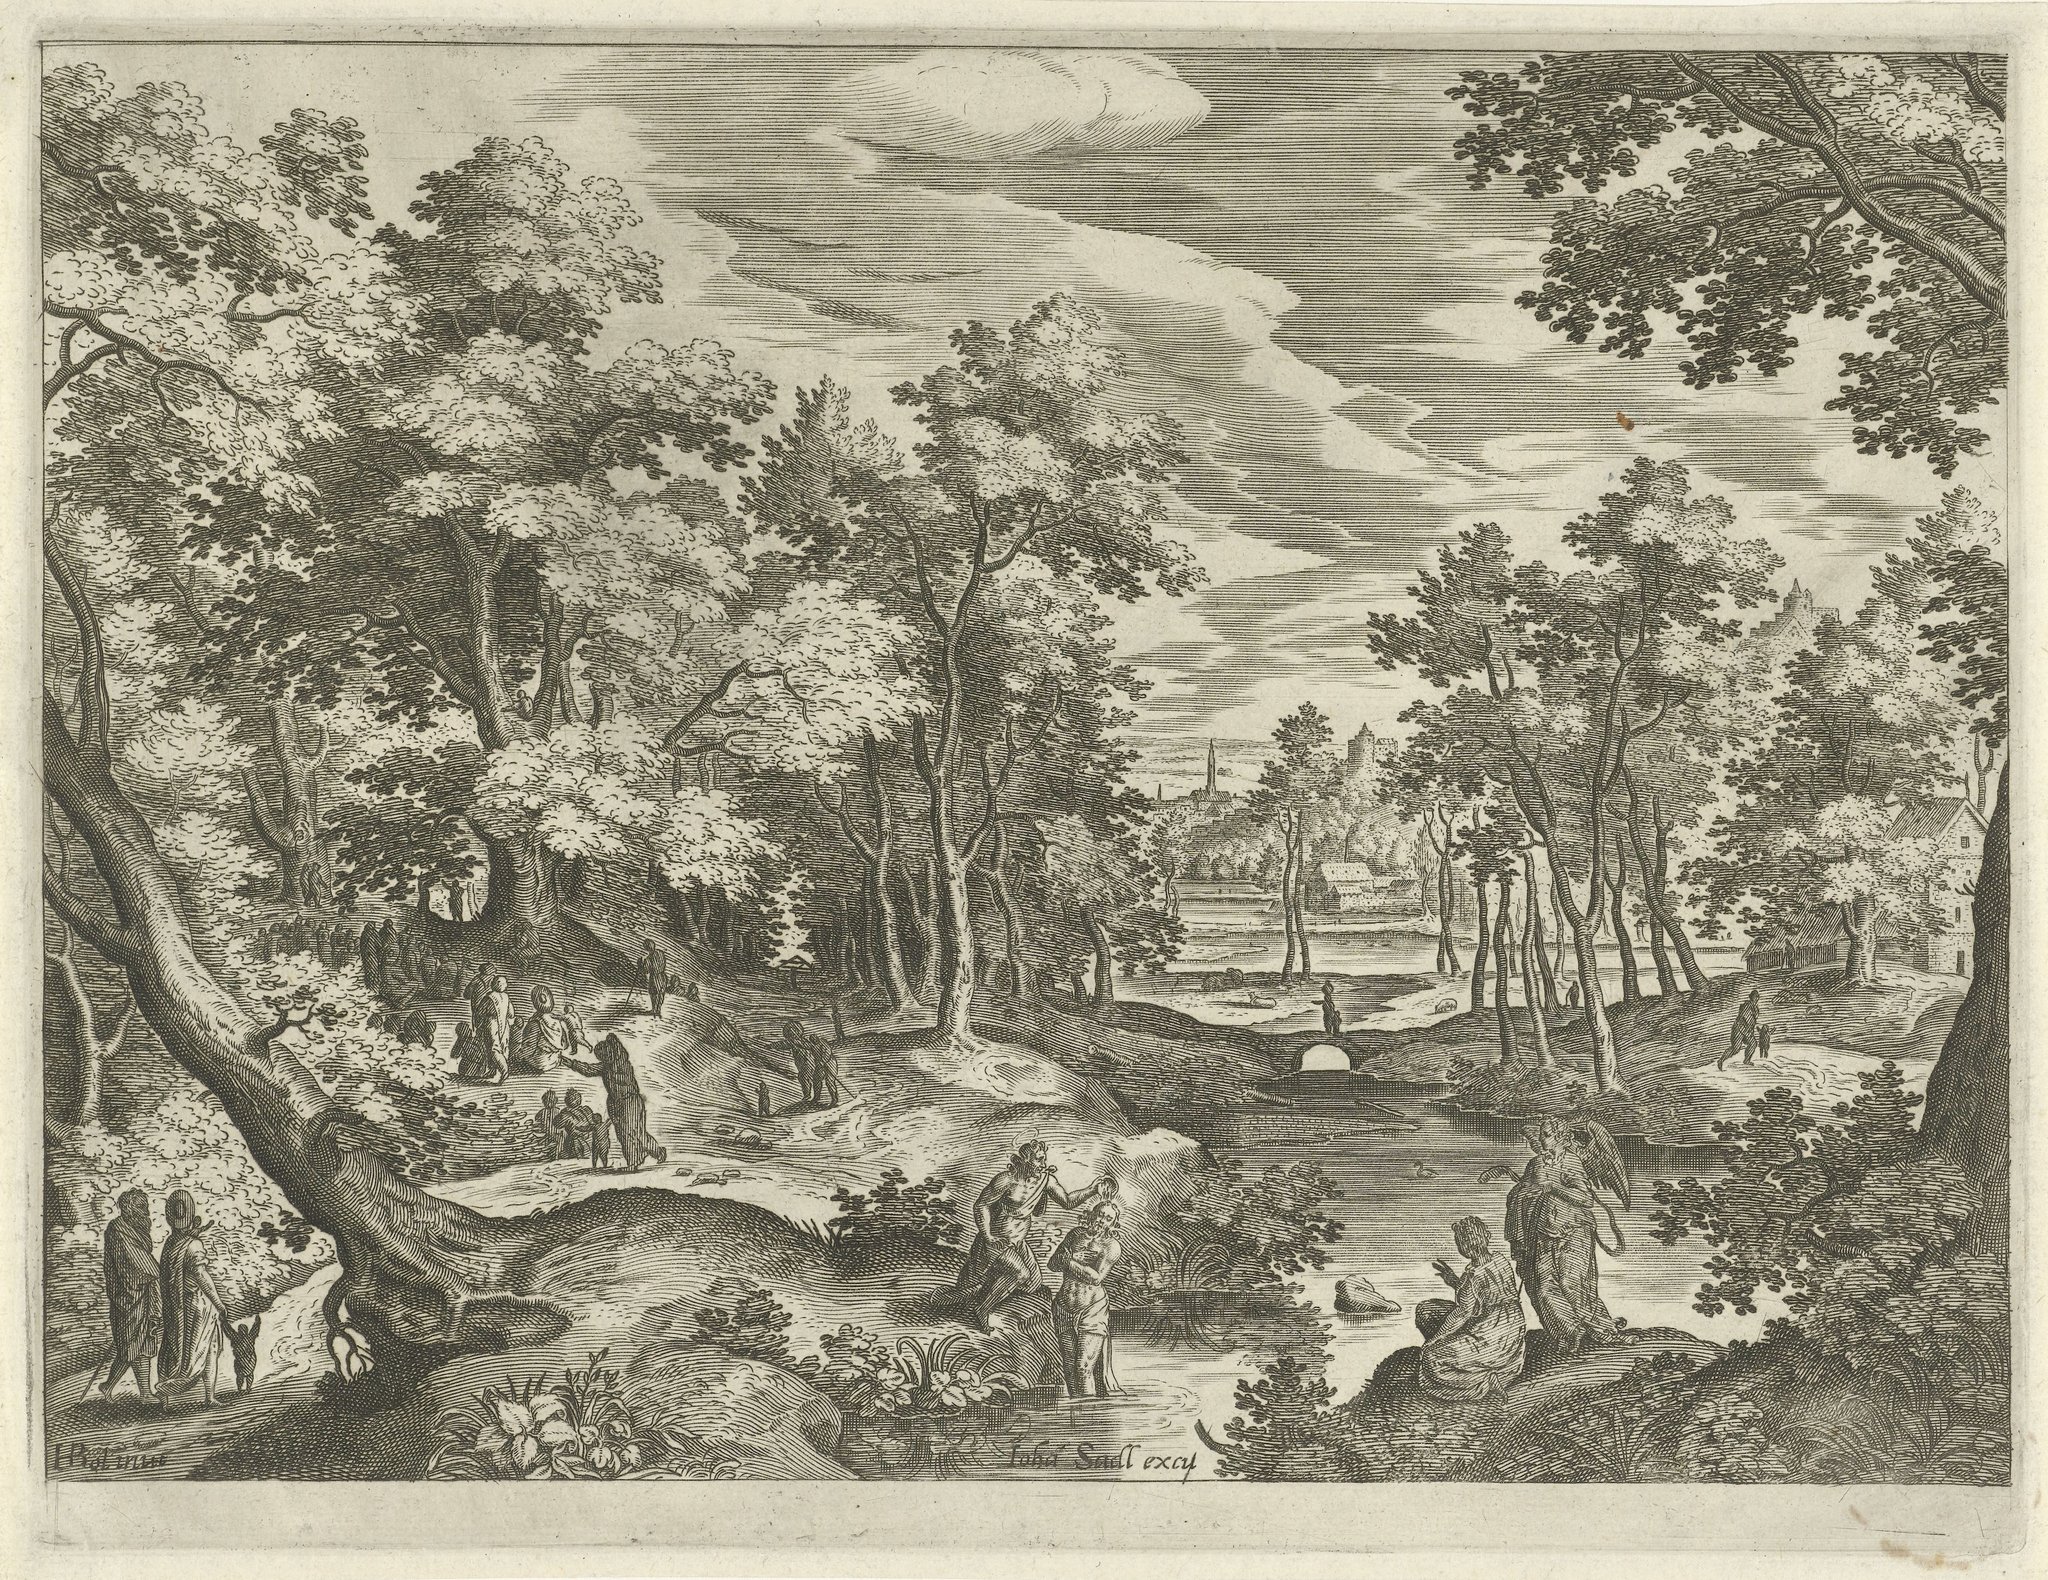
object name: print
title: Landschappen met scènes uit het Oude en Nieuwe Testament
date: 1580-1600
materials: paper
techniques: engraving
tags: baptism of christ in the river jordan: john the baptist pouring out water on christ's head: the holy ghost descends, river, forest, wood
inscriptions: collector's mark: Lugt 240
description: Bebost landschap met een rivier. In het midden wordt Christus door Johannes de Doper in de rivier gedoopt. Engelen houden Christus zijn kleren vast op de oever. Op de achtergrond predikt Johannes de Doper op een open plek in een bos. De prent is deel van een achtdelige serie van landschappen met scènes uit het Oude en Nieuwe Testament.